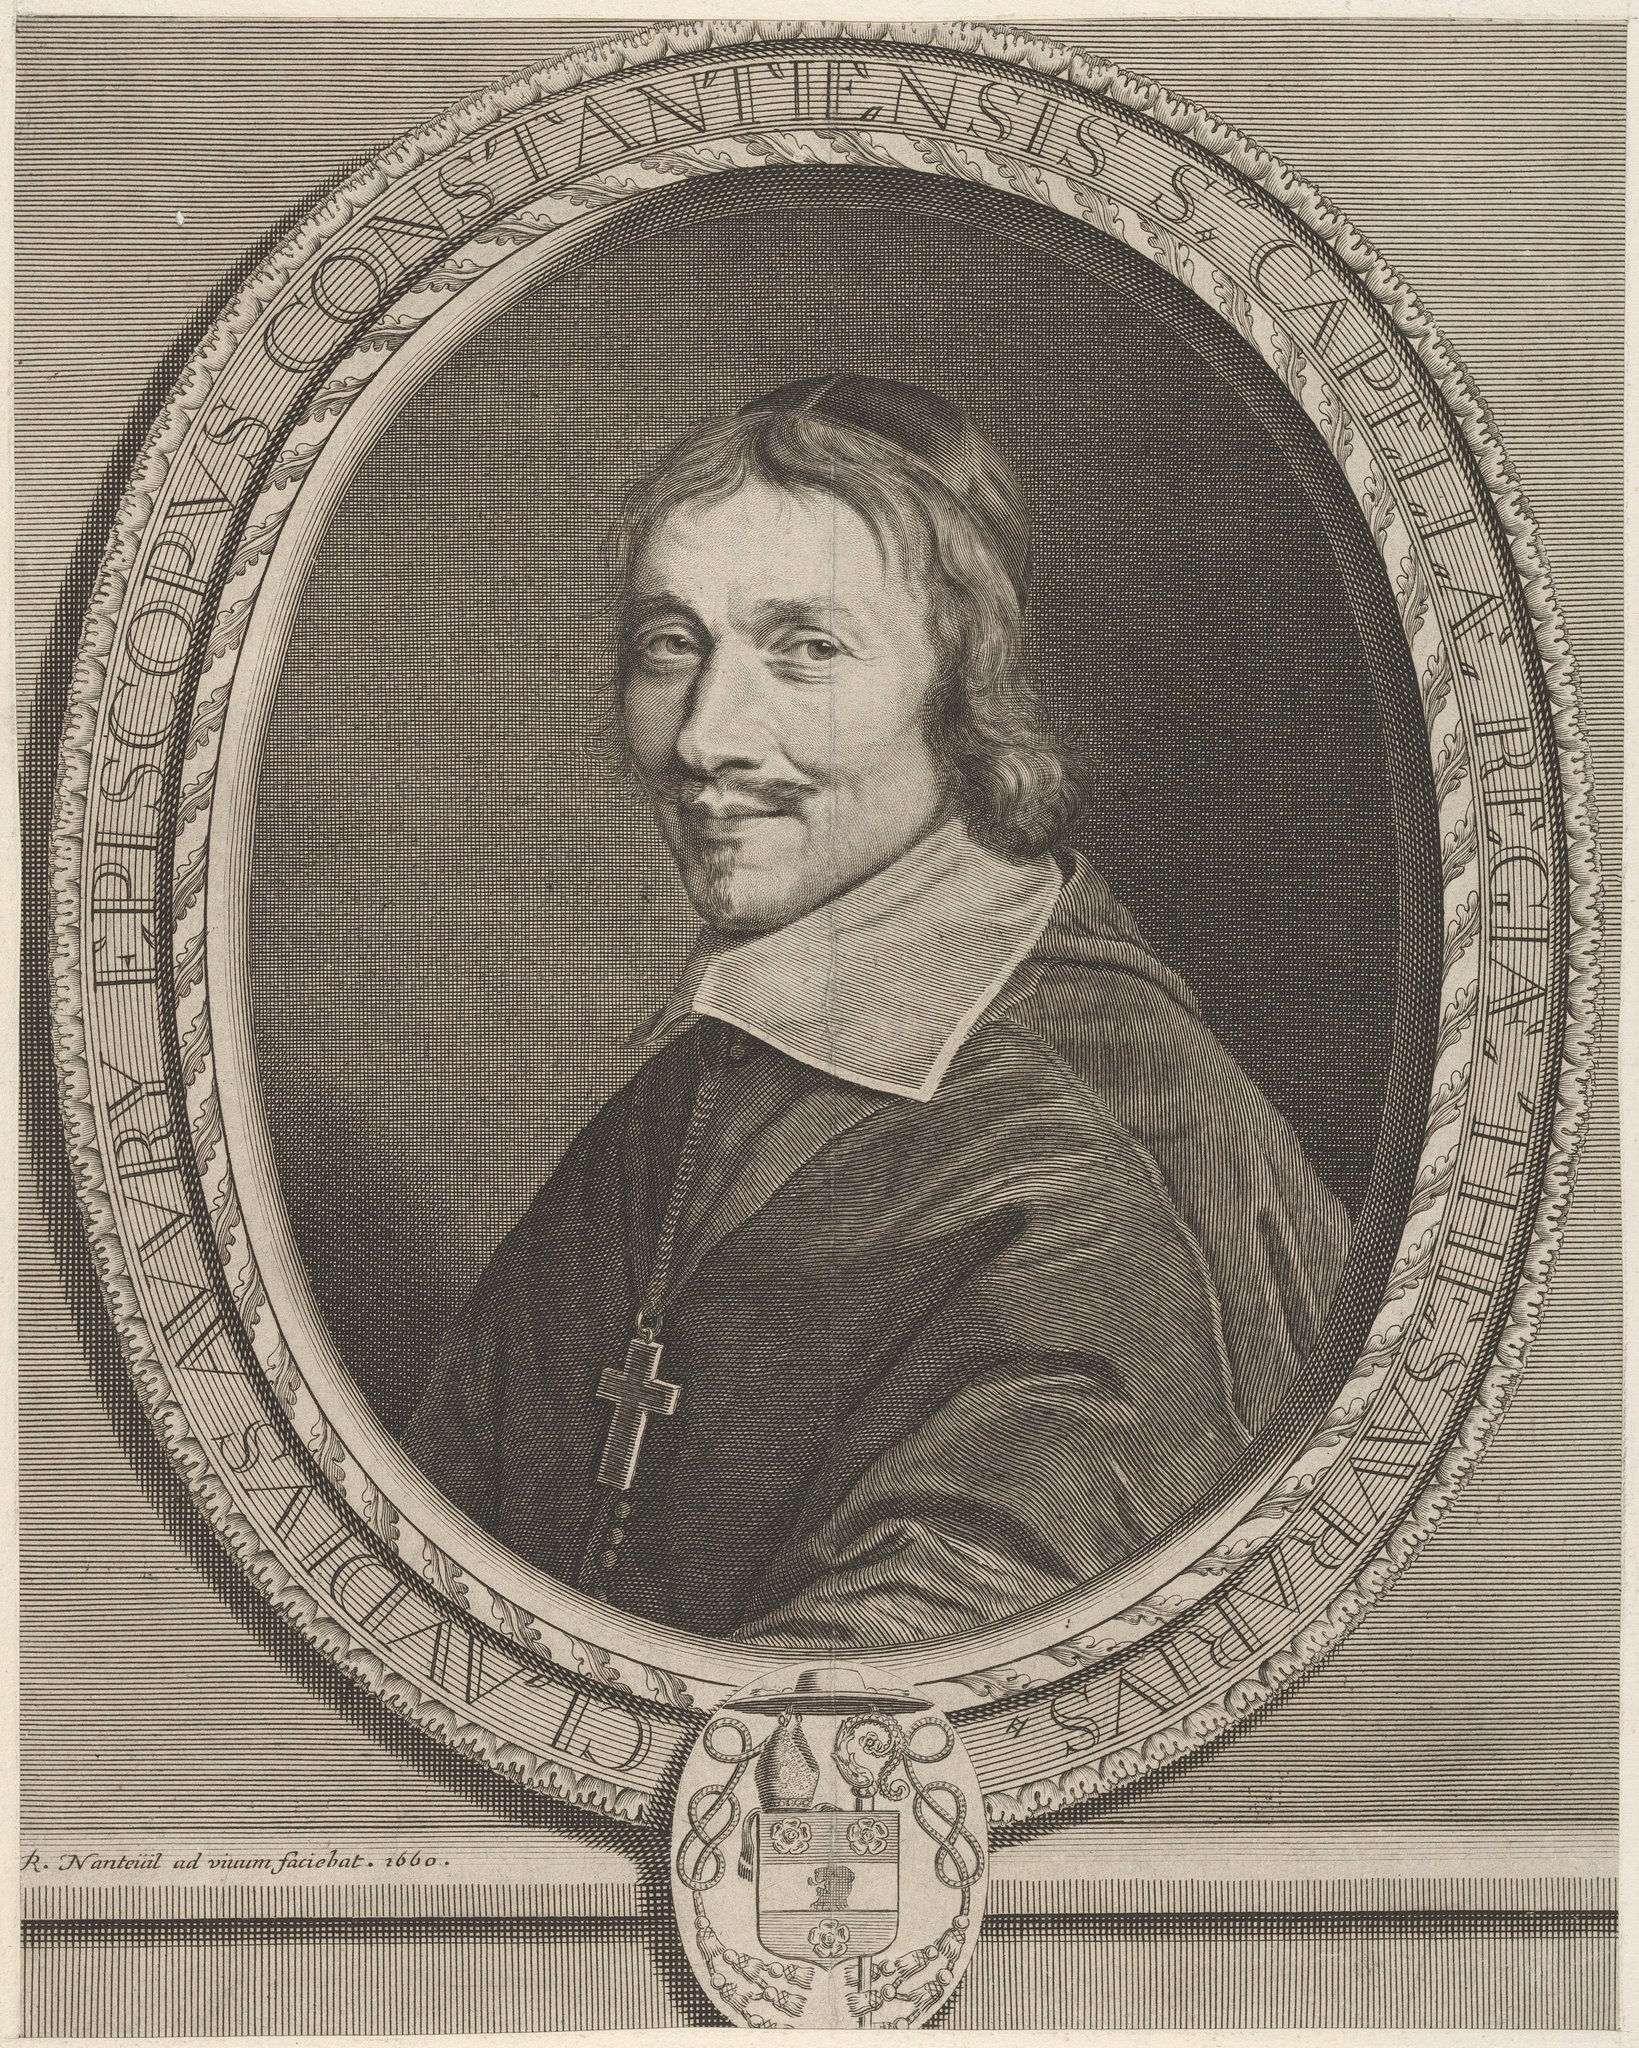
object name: print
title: Claude Auvry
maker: robert nanteuil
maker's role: artist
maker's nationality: french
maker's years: 1623-1678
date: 1660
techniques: engraving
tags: men,portraits,bishops,cross,coat of arms